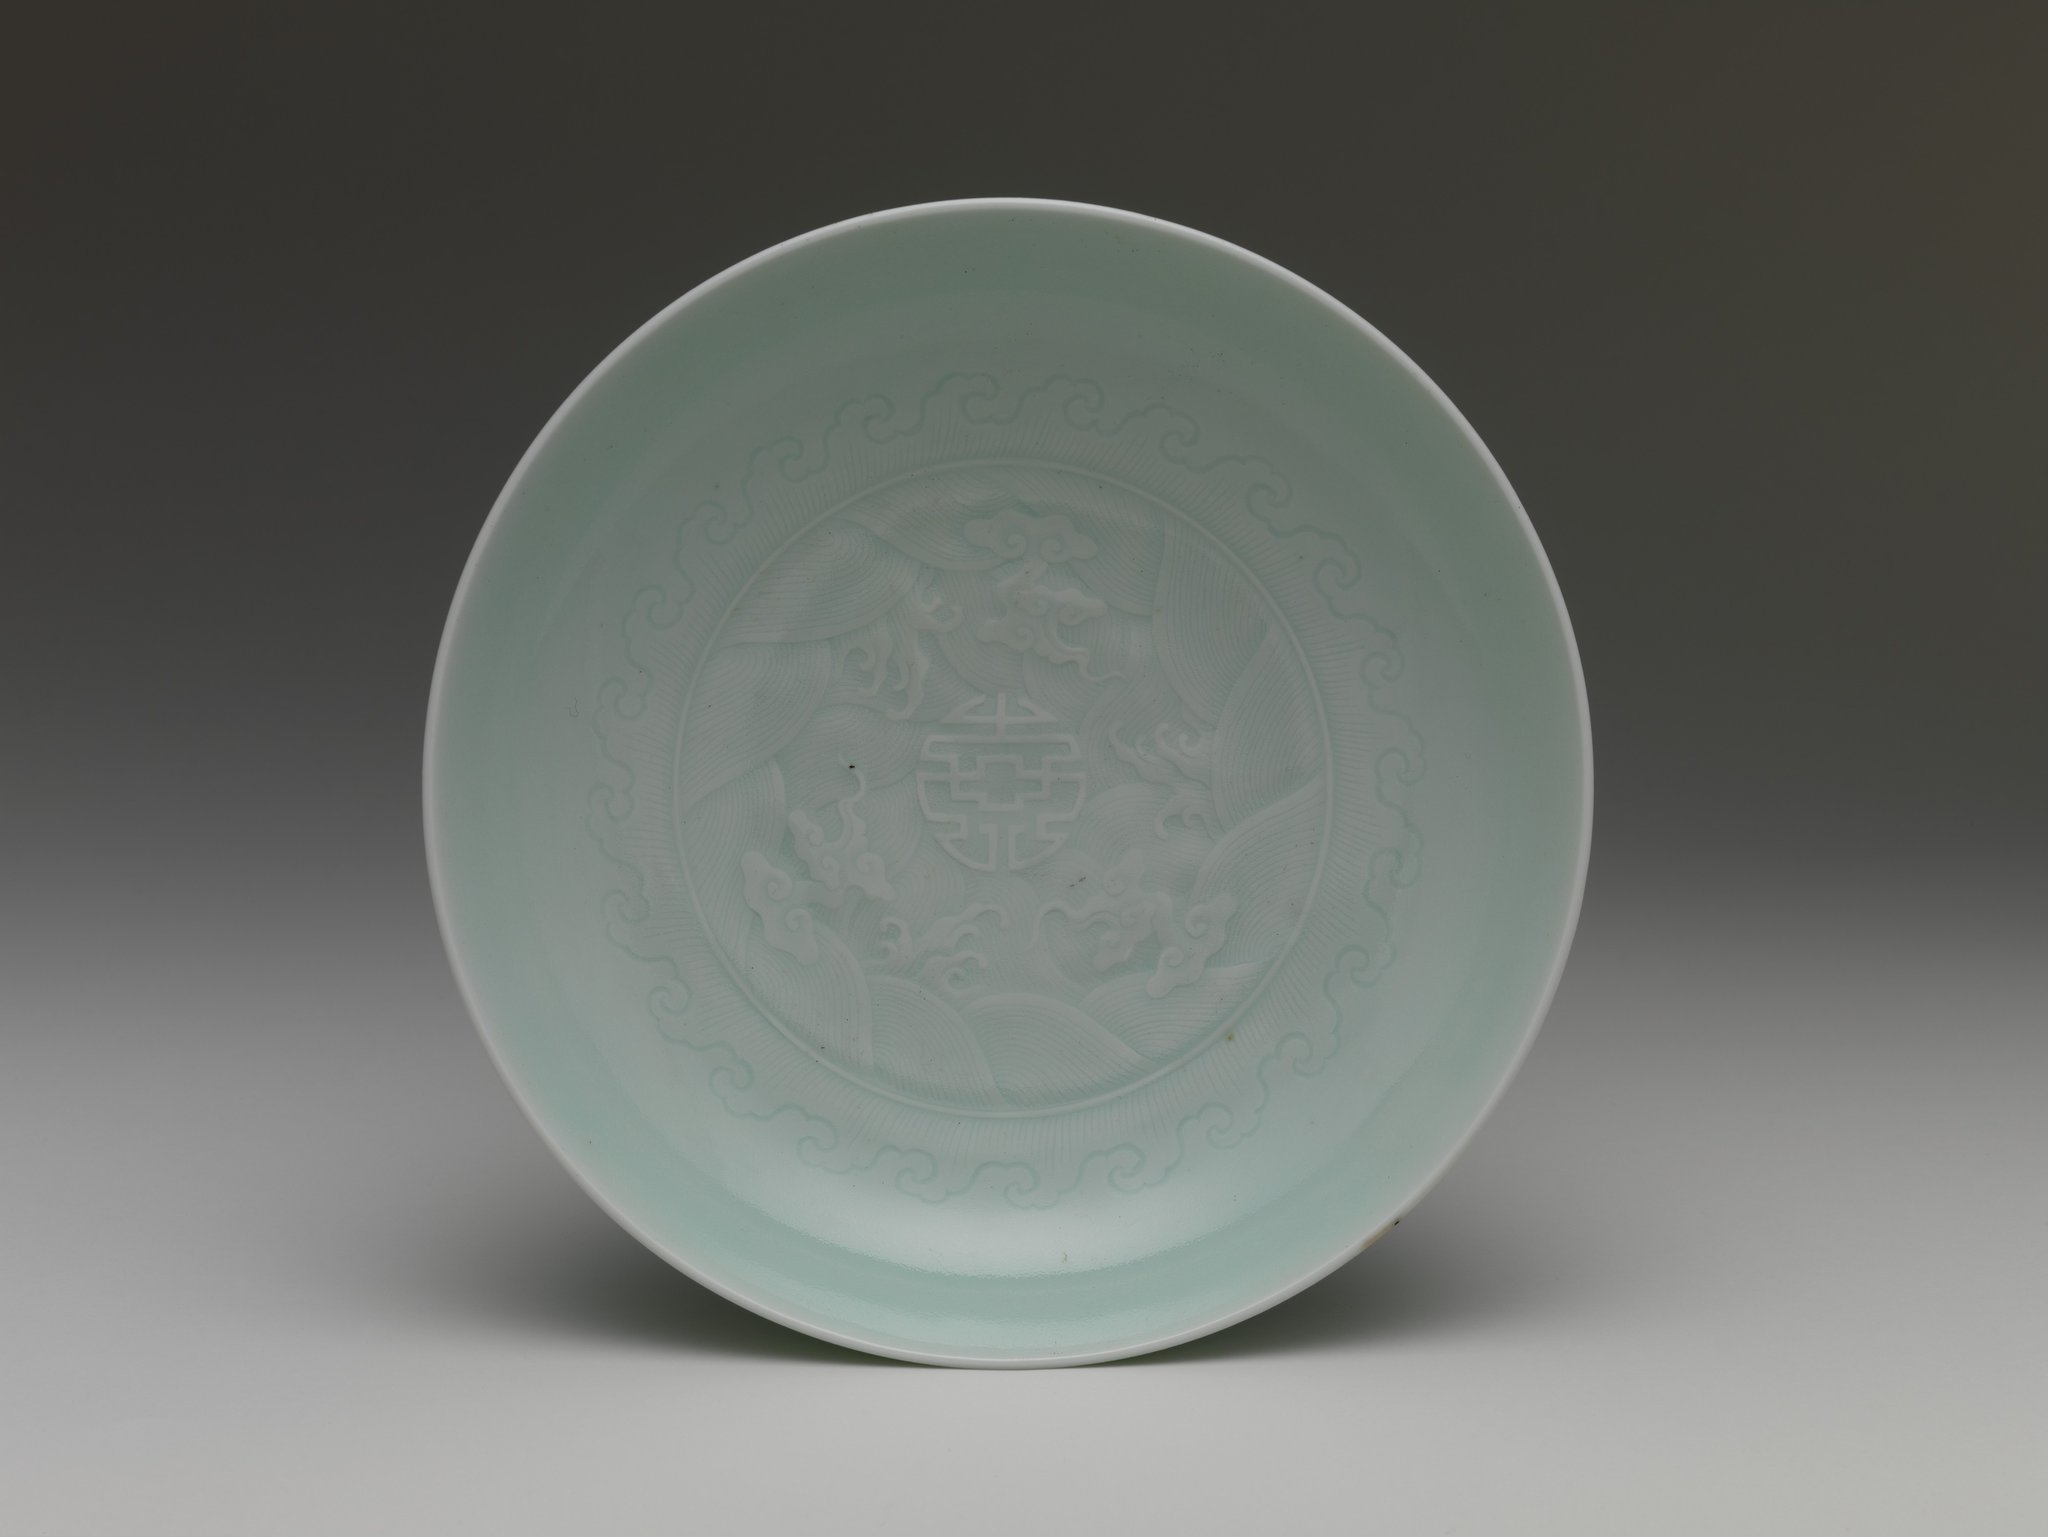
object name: dish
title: Dish with Carved Decoration of Character for Longevity (Shou)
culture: chinese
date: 1701-1800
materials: ceramic glaze, glaze, porcelain